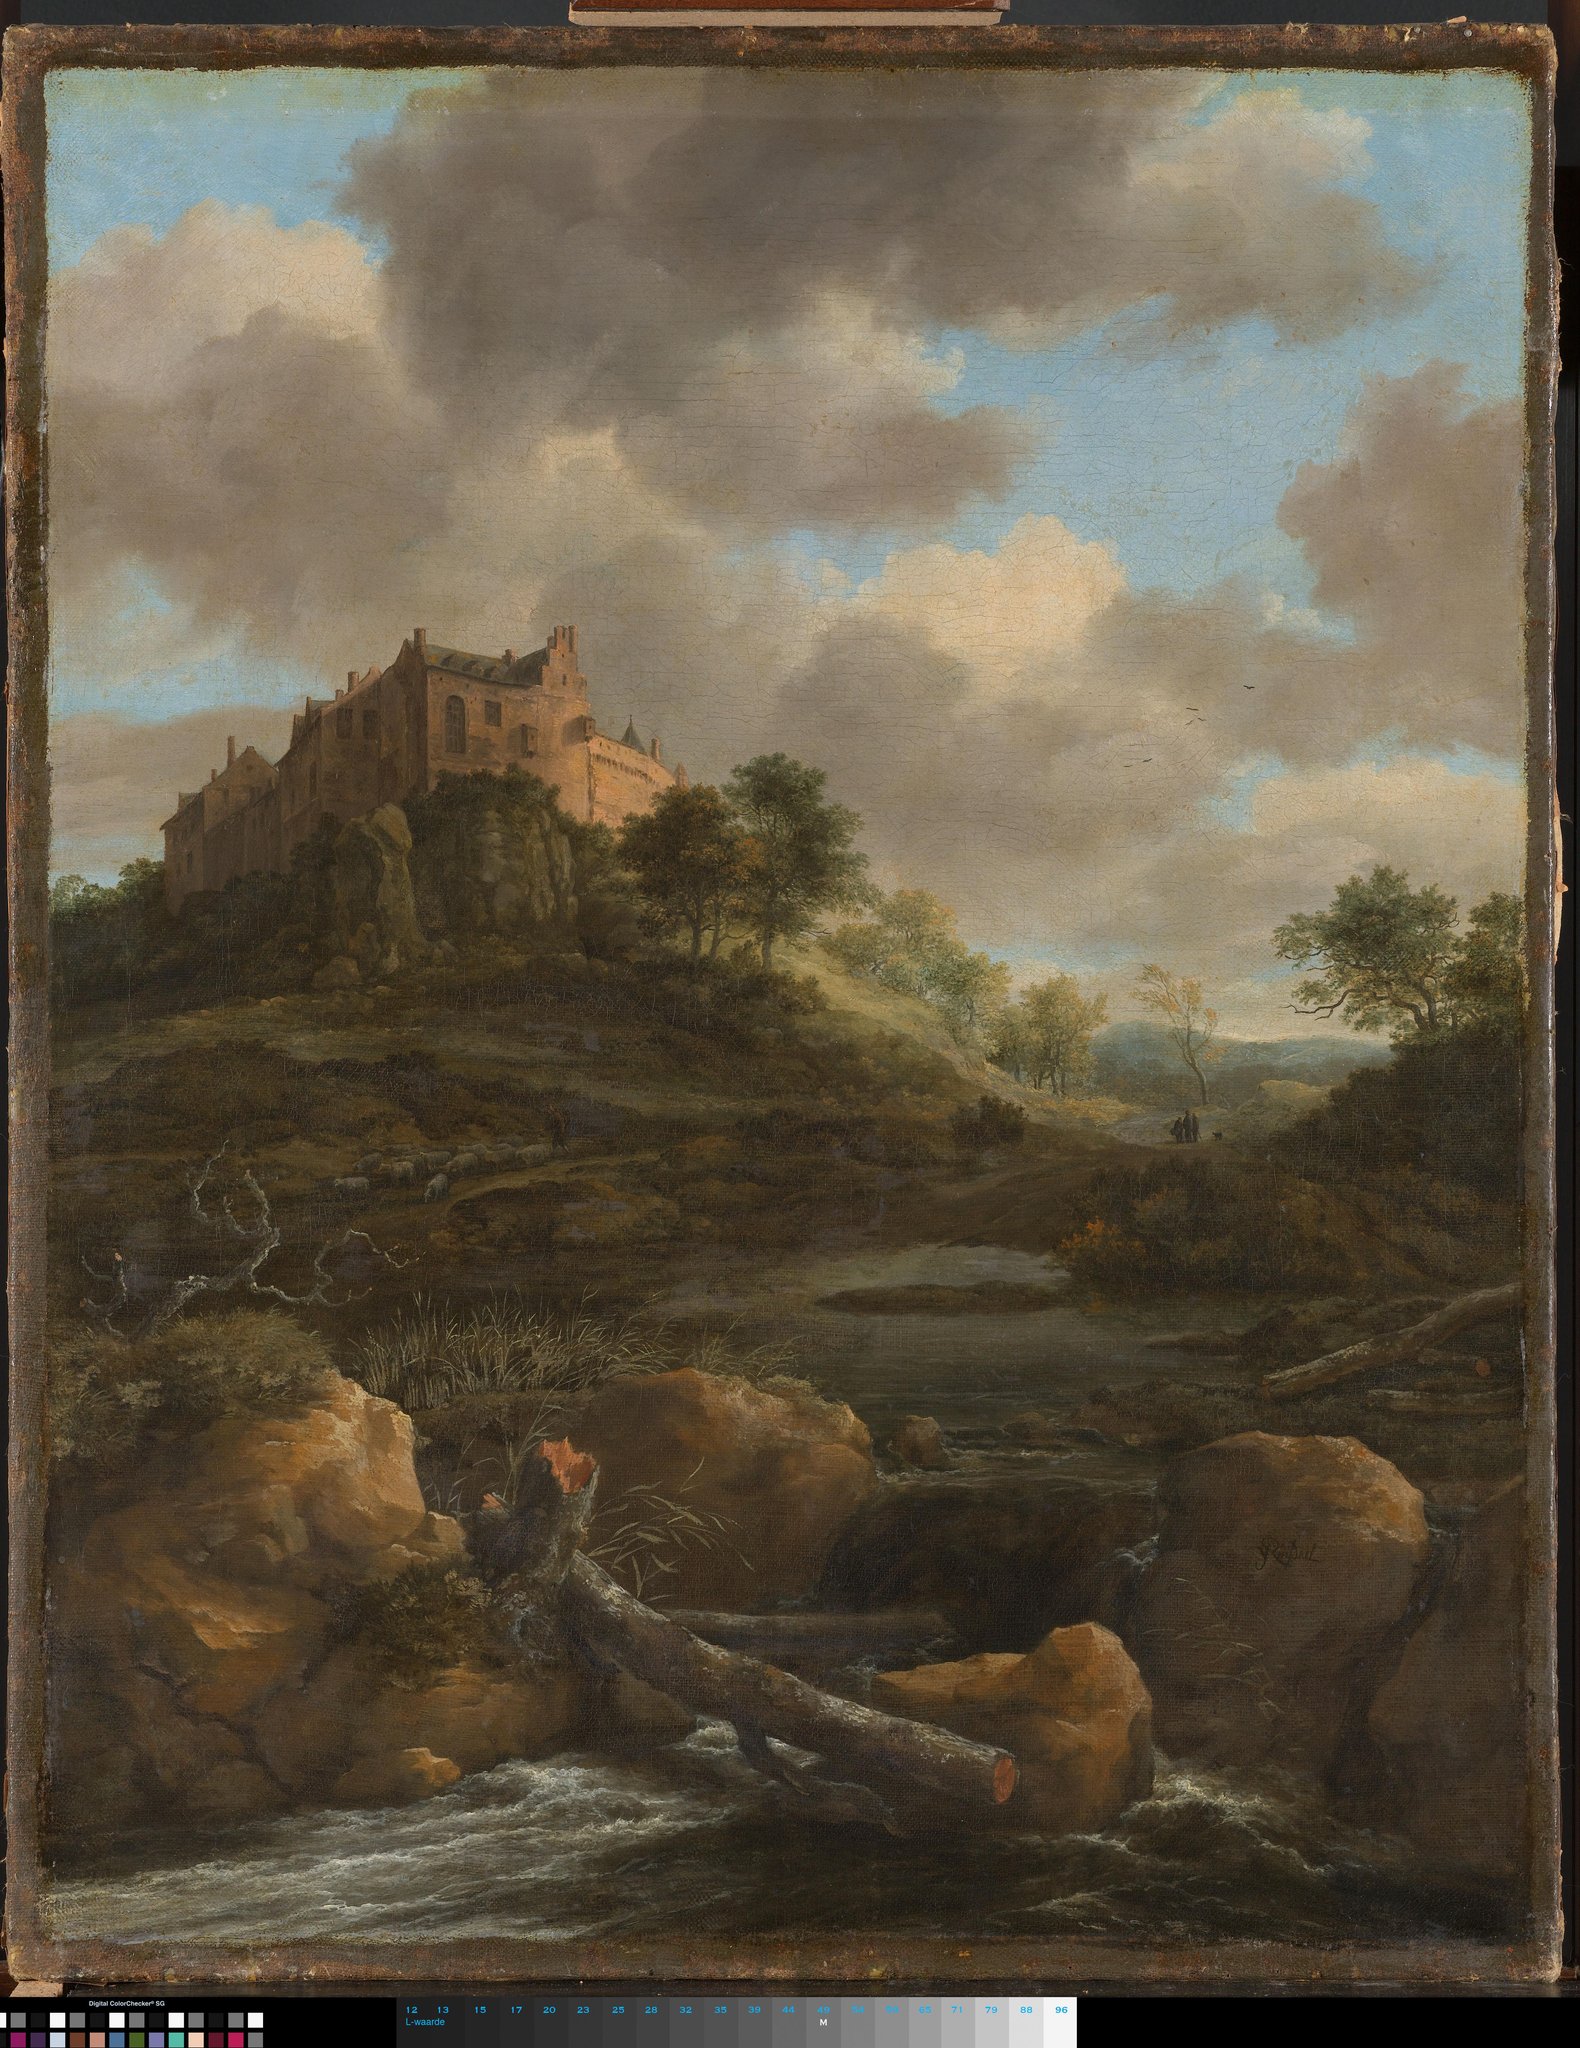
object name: painting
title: Bentheim Castle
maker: jacob isaacksz van ruisdael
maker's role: draughtsman, painter, print maker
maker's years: 1628-1682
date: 1650-1682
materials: canvas, oil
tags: brook, landscape with tower or castle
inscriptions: signature: ‘JVRuisdael’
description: Bentheim Castle still exists. It is located on the German–Dutch border region, but the high mountains Ruisdael depicted in this painting are not found there. Fantasy and reality are interwoven in this scene. The painter made a dozen paintings of this castle, each with a different mountain landscape. In 1861, Goethe, the famous German writer, rightly called Ruisdael a poet.